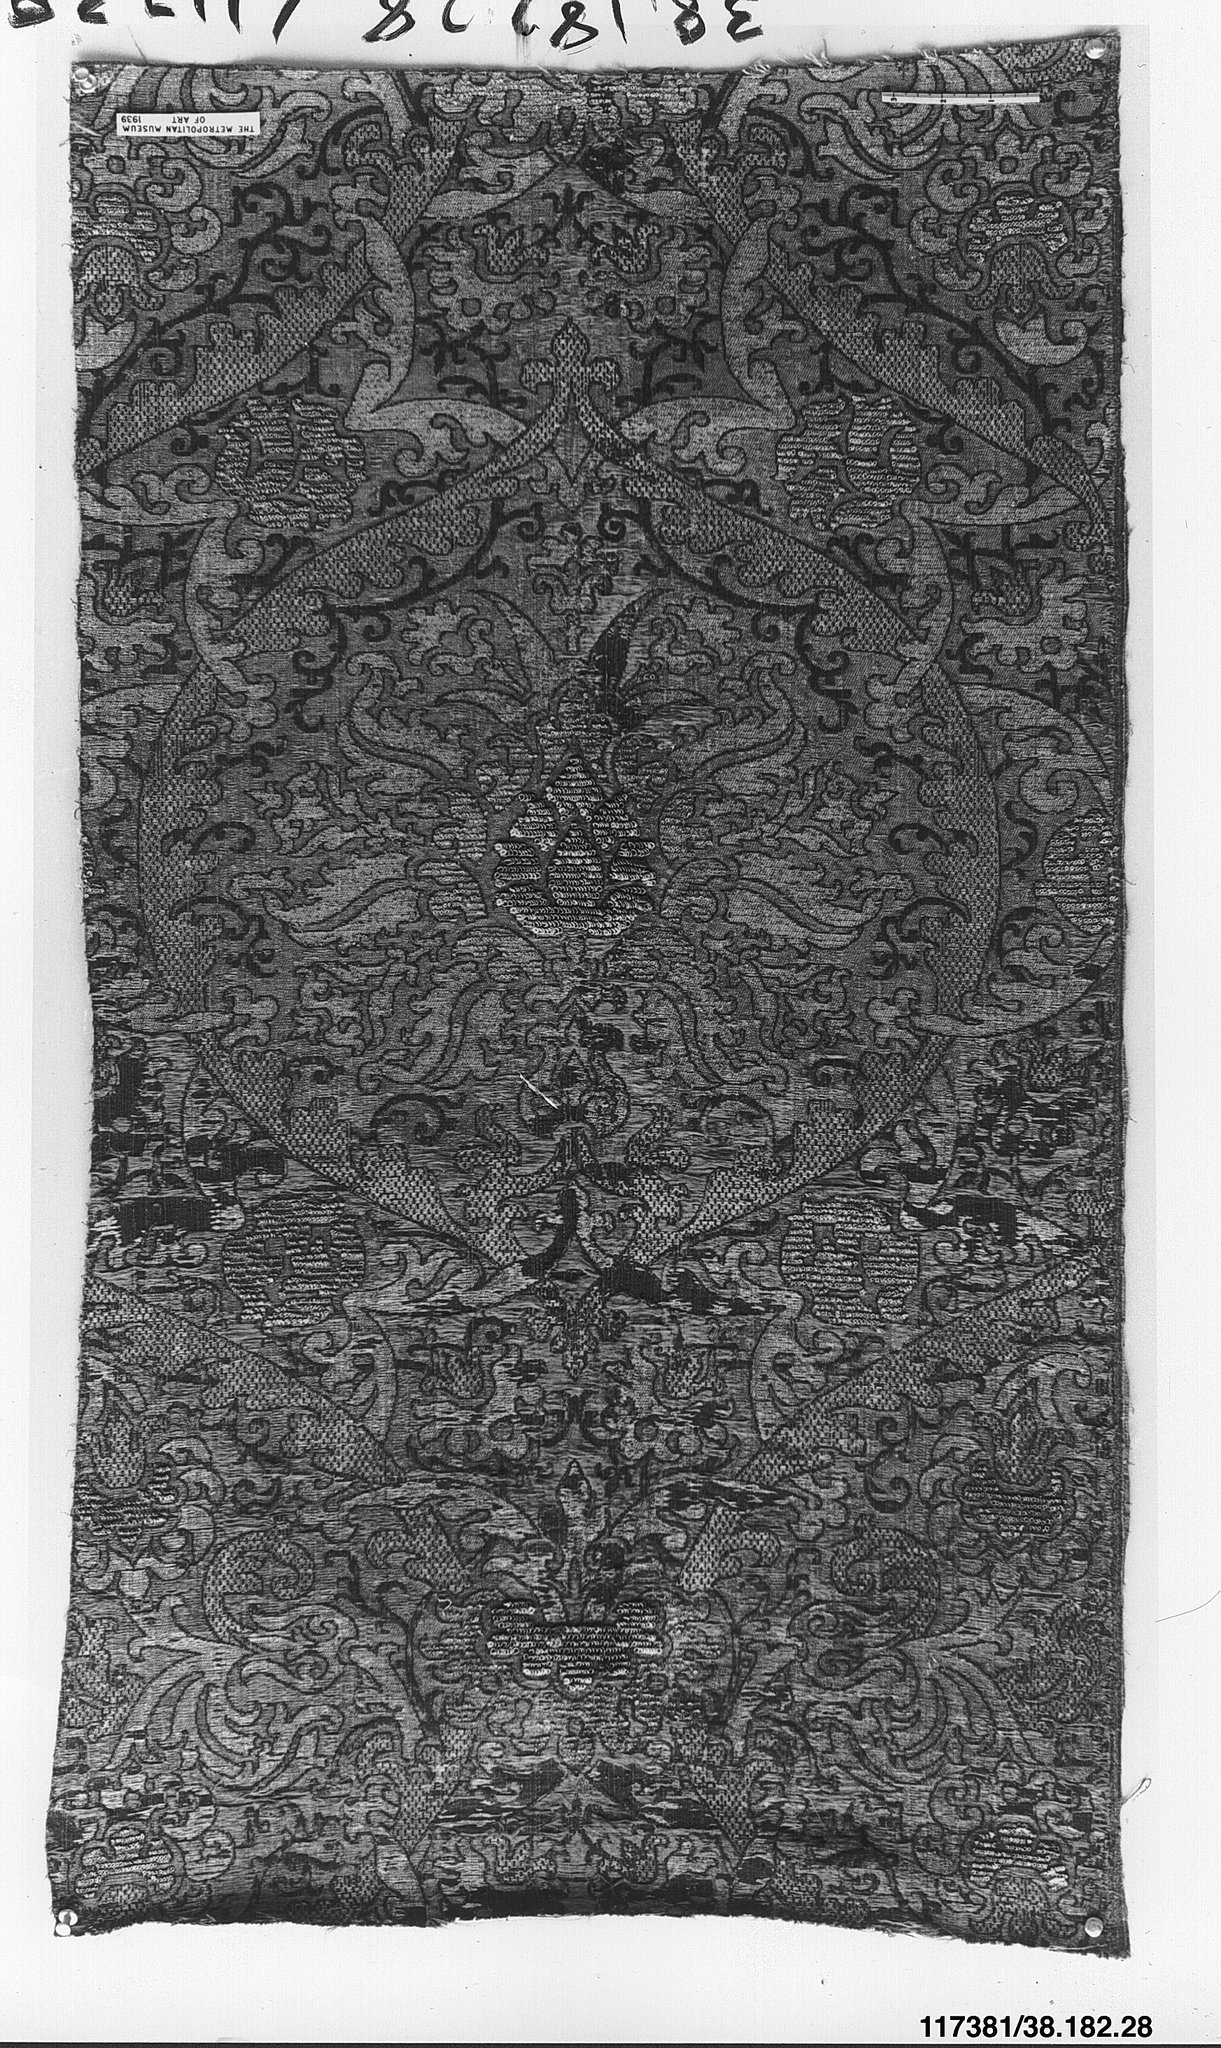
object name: piece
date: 1534-1566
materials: silk, thread